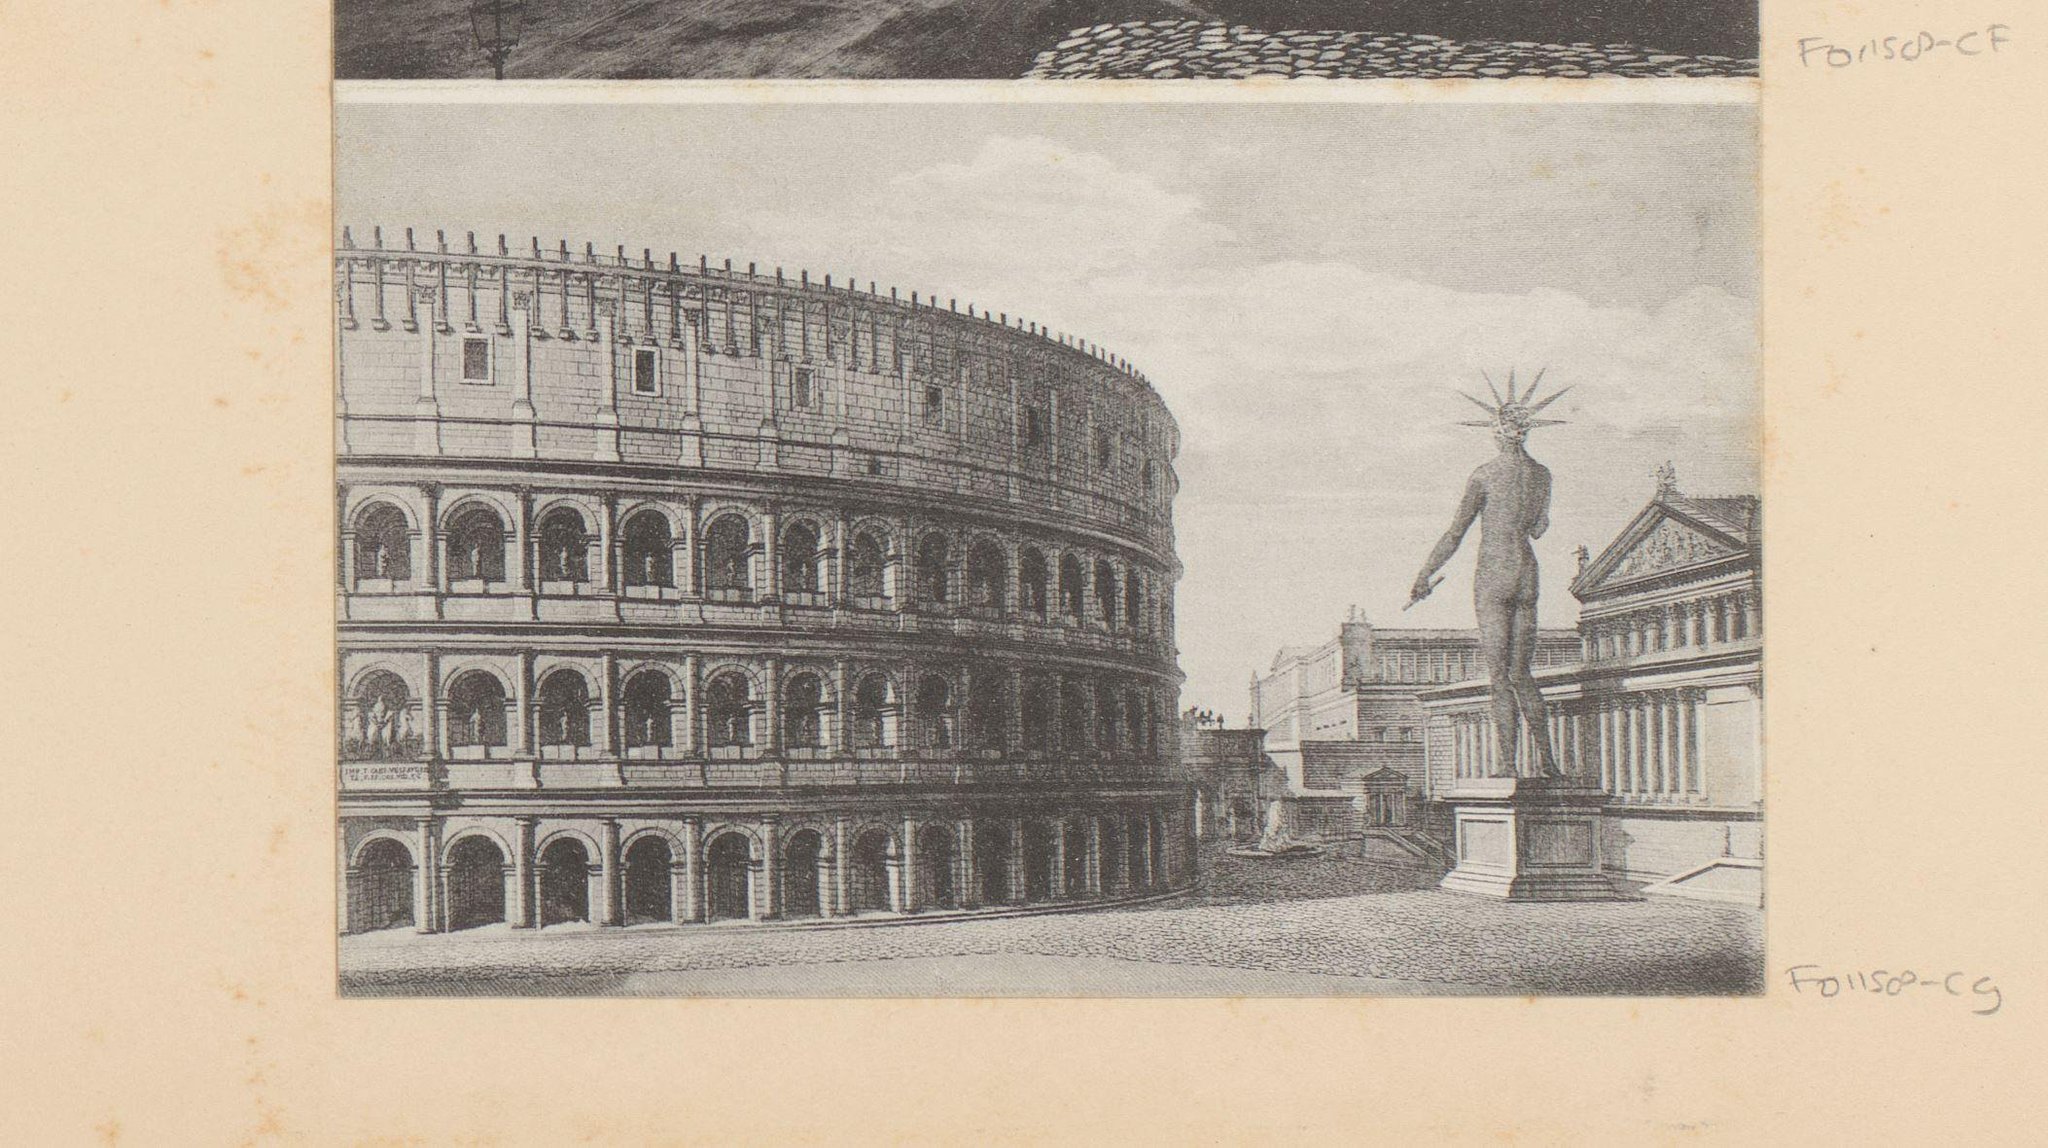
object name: reproduction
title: Fotoreproductie van een prent, voorstellende een gezicht op het Colosseum te Rome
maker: Anonymous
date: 1875-1907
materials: paper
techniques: photograph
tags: sculpture, façade (of house or building)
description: Onderdeel van Fotoalbum met opnames van bezienswaardigheden en kunstwerken in Italië.